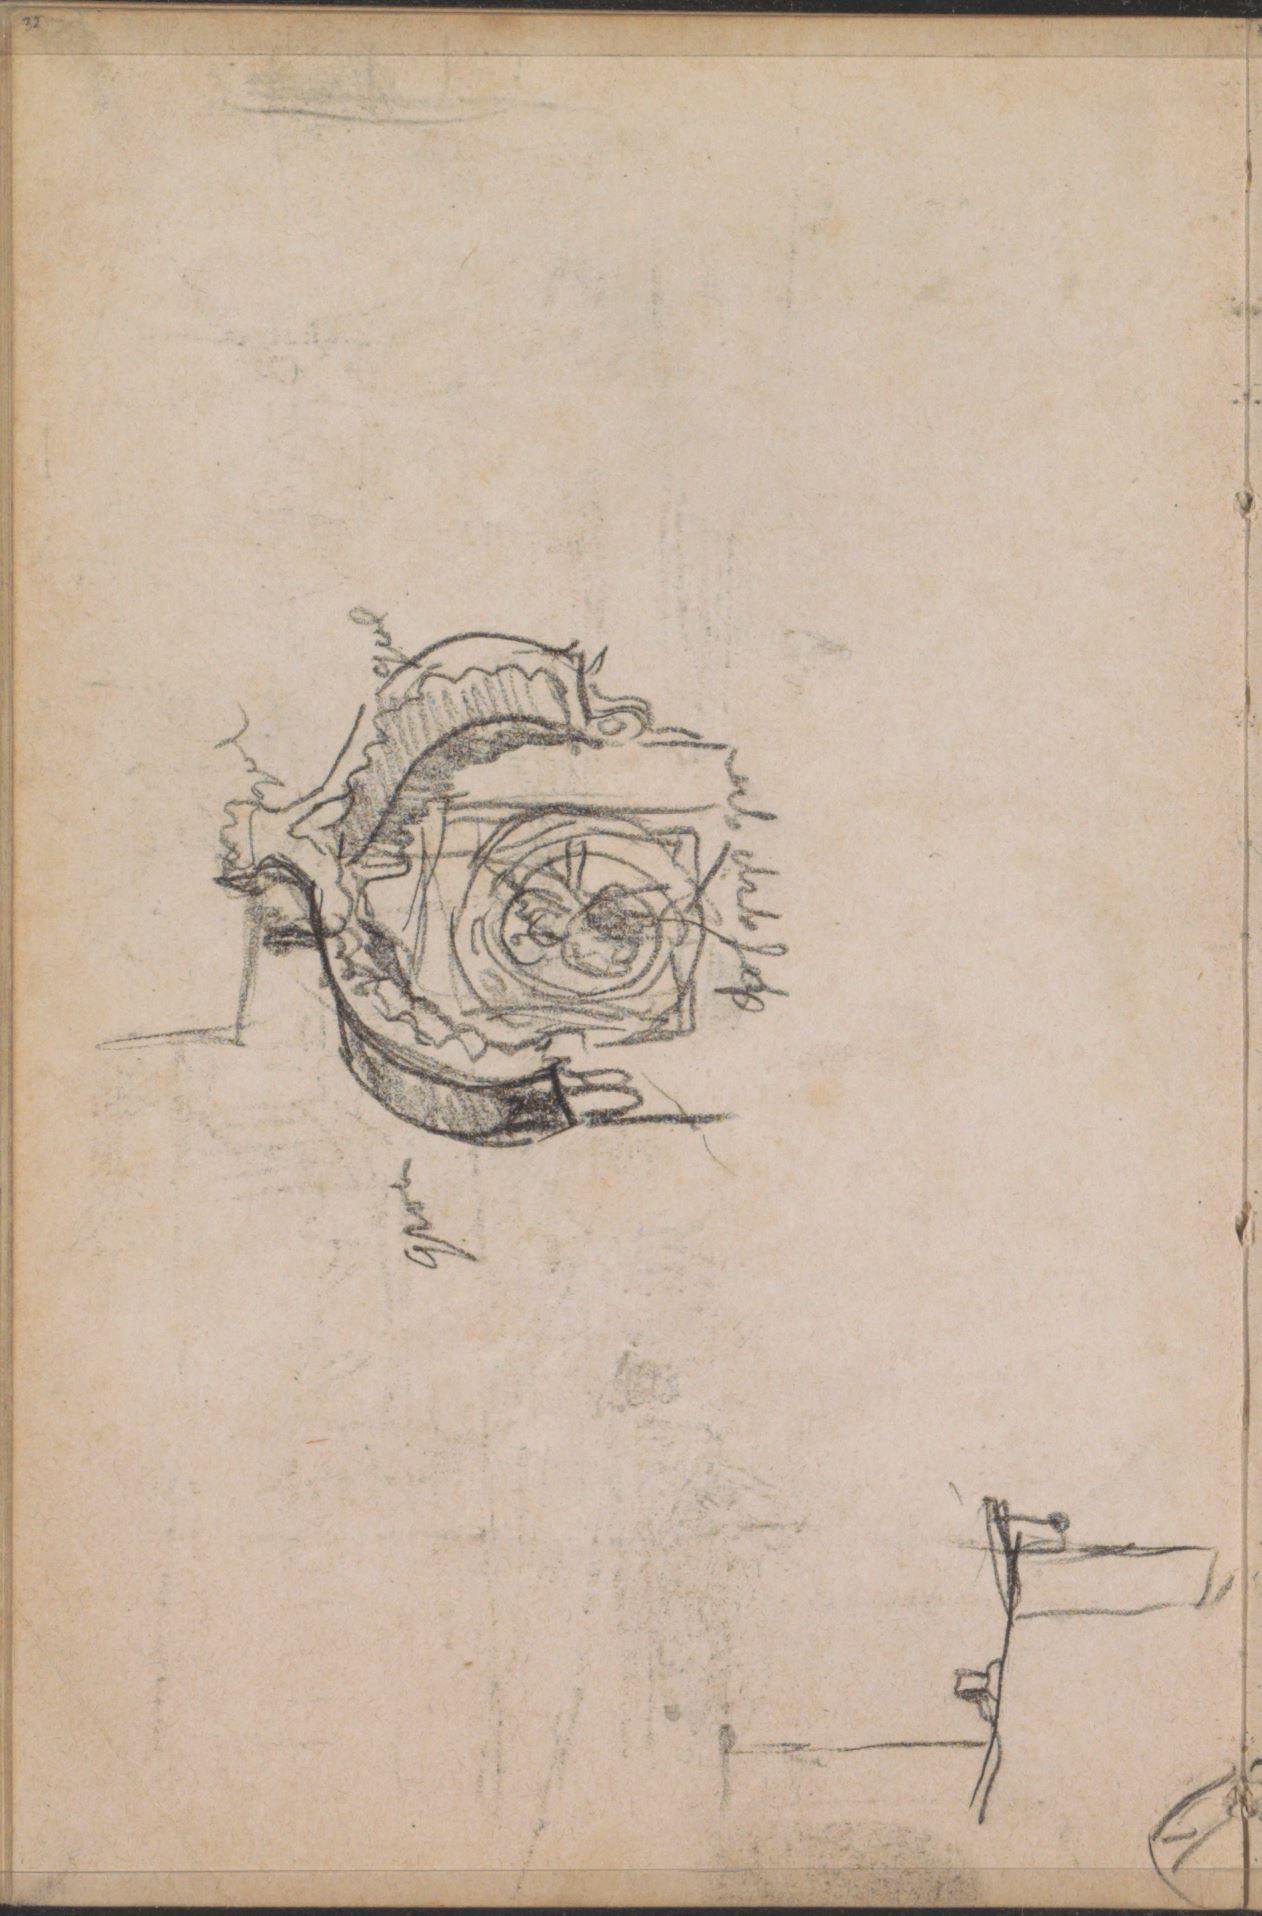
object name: sketchbook leaf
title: Torenspits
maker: marius bauer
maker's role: draughtsman, print maker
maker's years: 1867-1932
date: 1896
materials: chalk, paper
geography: moscow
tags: parts of church exterior and annexes: spire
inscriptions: kleurnotitie, handgeschreven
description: Mogelijk van één van de torens van het Kremlin van Moskou. Pagina 32 uit een schetsboek met 45 bladen.